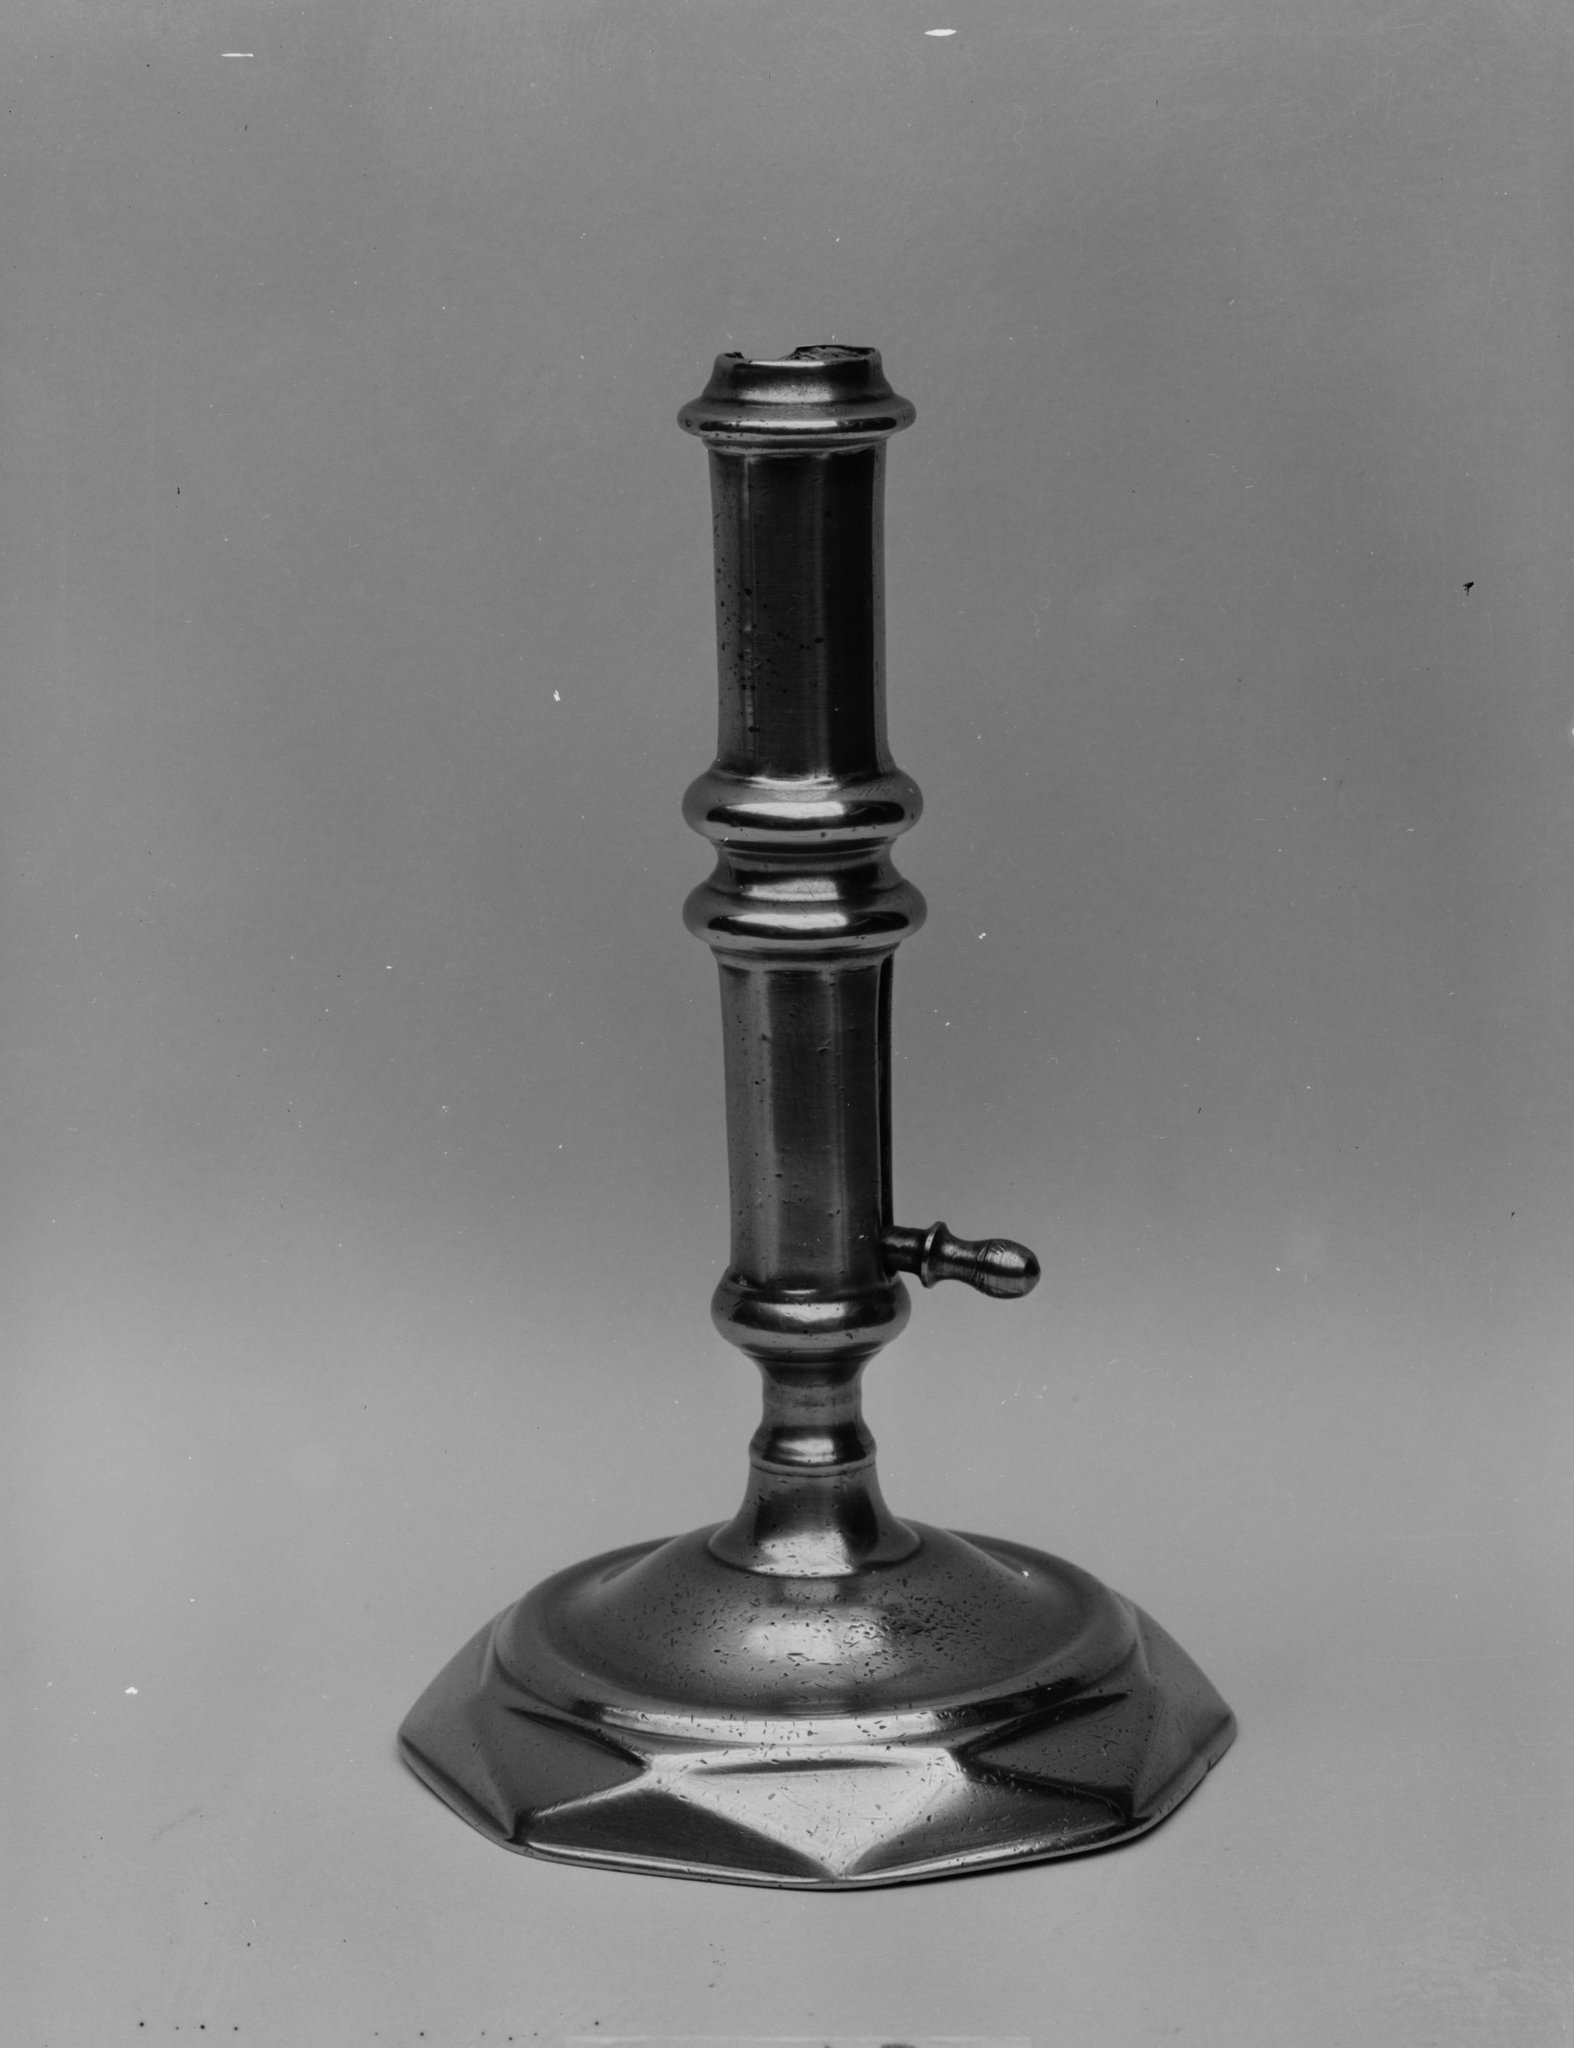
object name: candlestick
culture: american or british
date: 1700-1800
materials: brass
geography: england